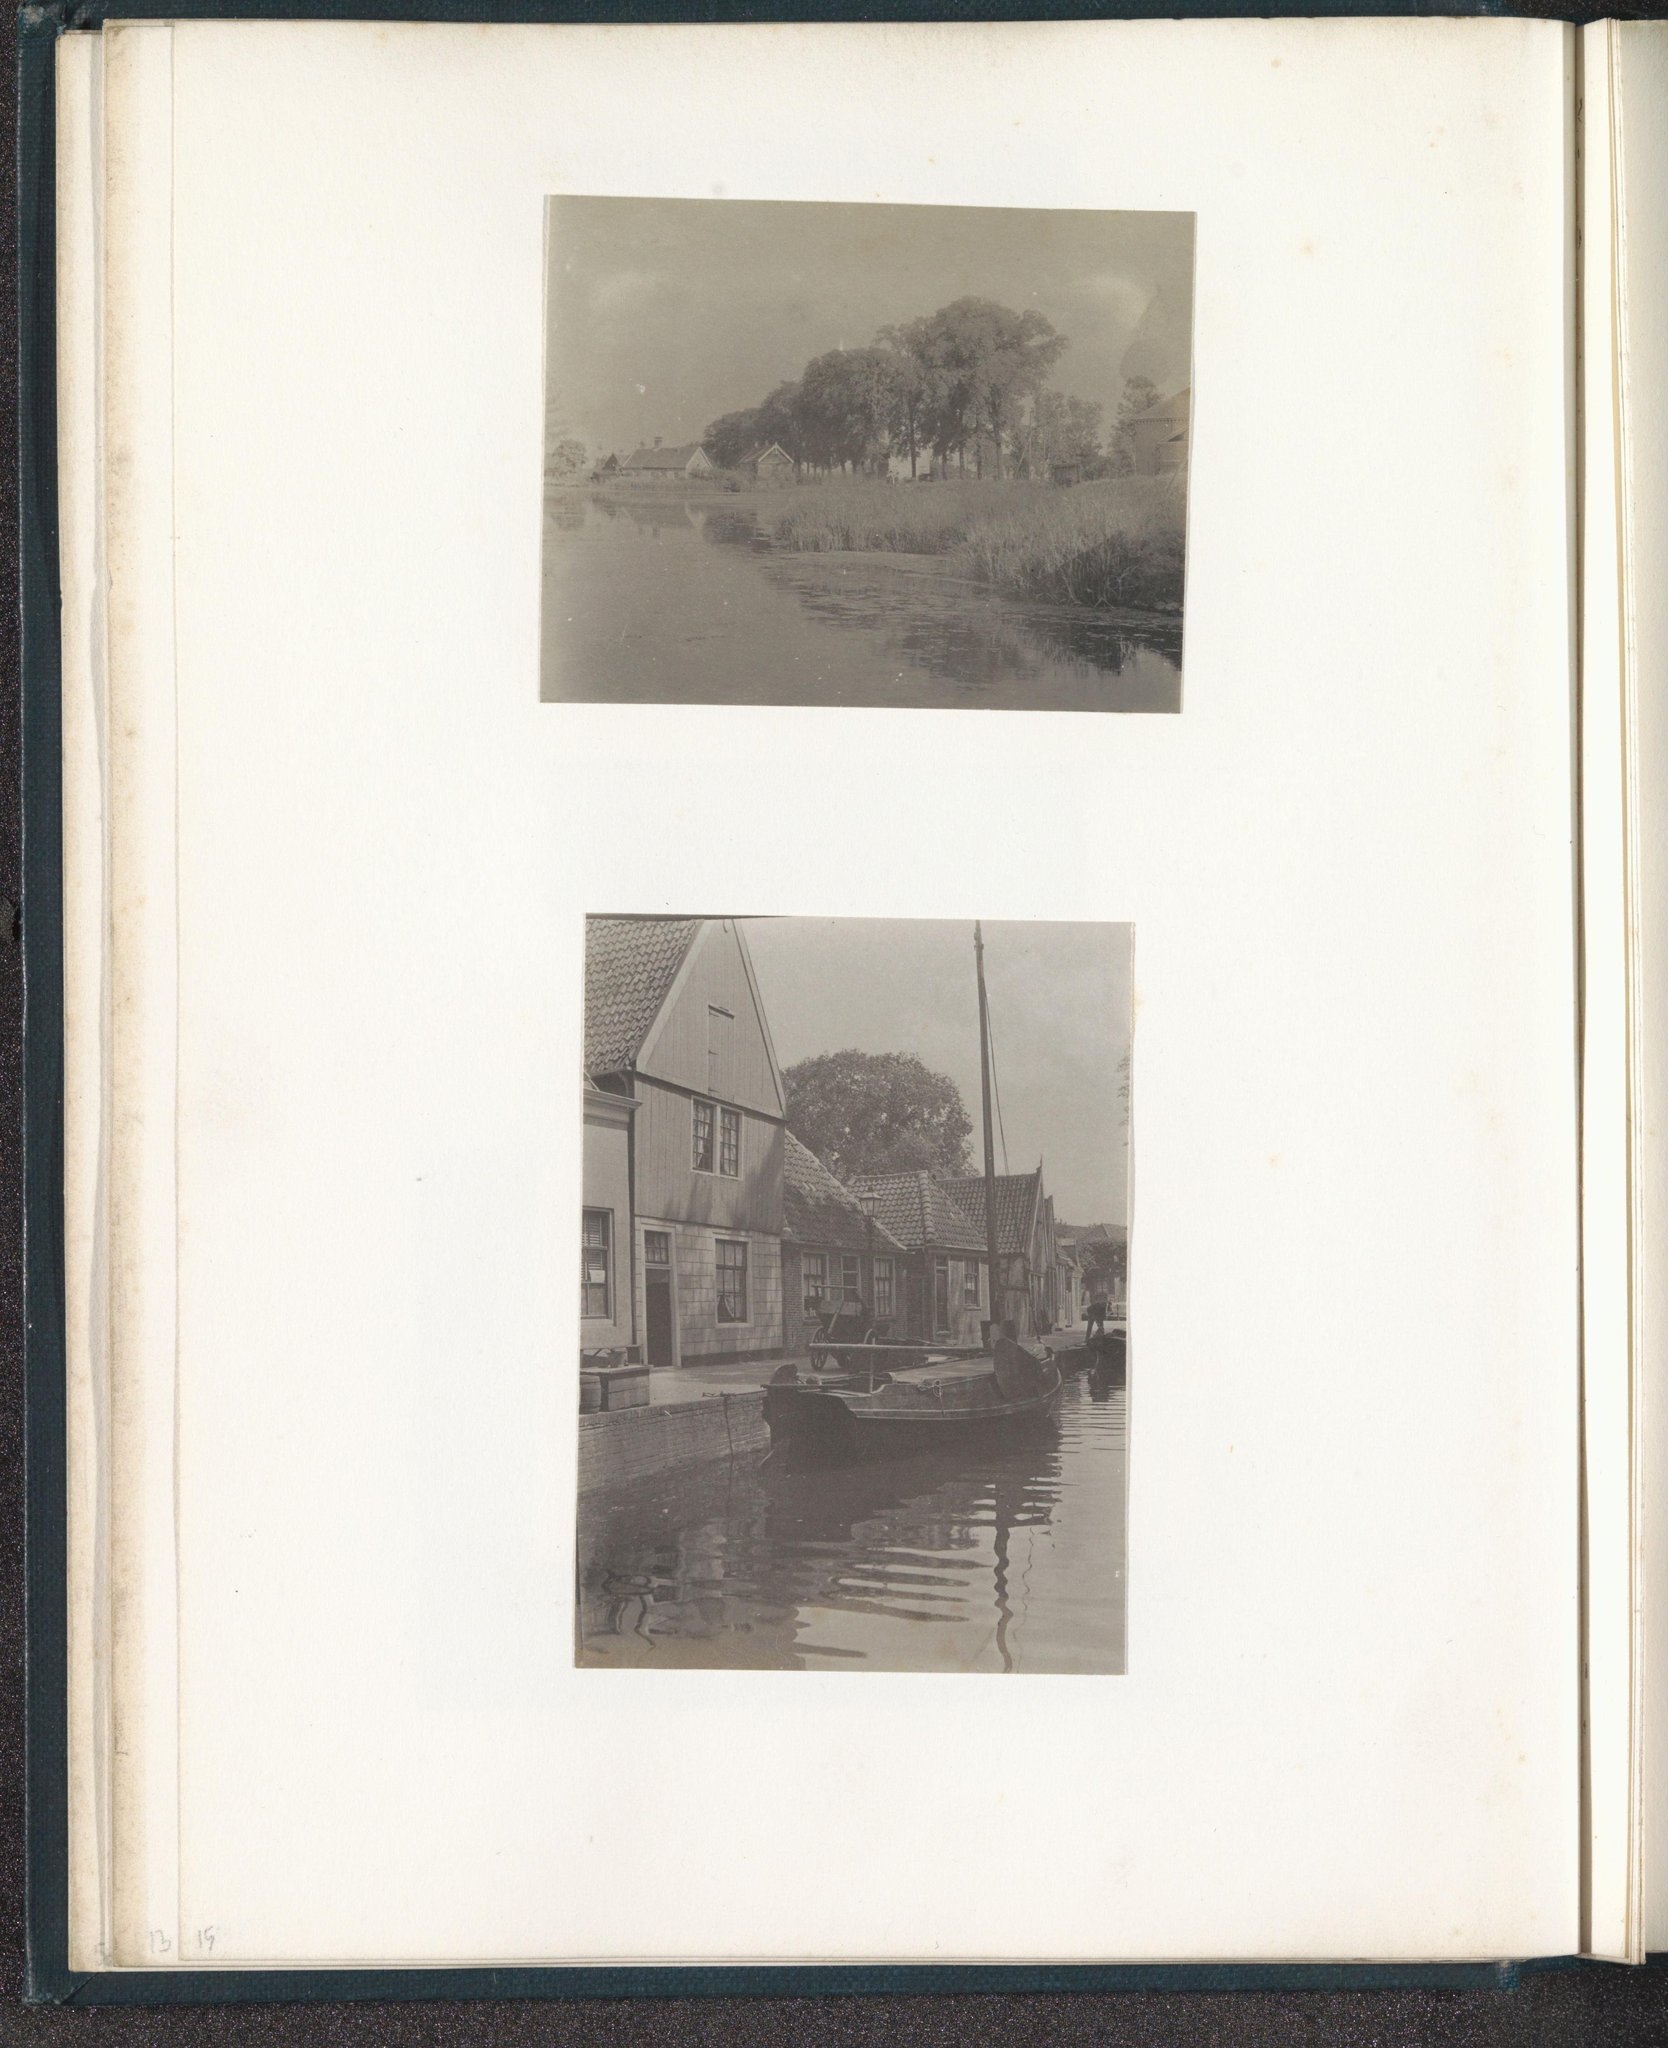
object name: photograph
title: Kade met huizen en zeilboot, vermoedelijk bij Volendam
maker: george hidderley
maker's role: fotograaf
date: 1900-1910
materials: paper, photographic support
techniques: gelatin silver print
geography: volendam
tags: sailing-ship, sailing-boat, quay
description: Onderdeel van fotoalbum met opnames van Volendam, Dordrecht, Gorinchem en Woudrichem.